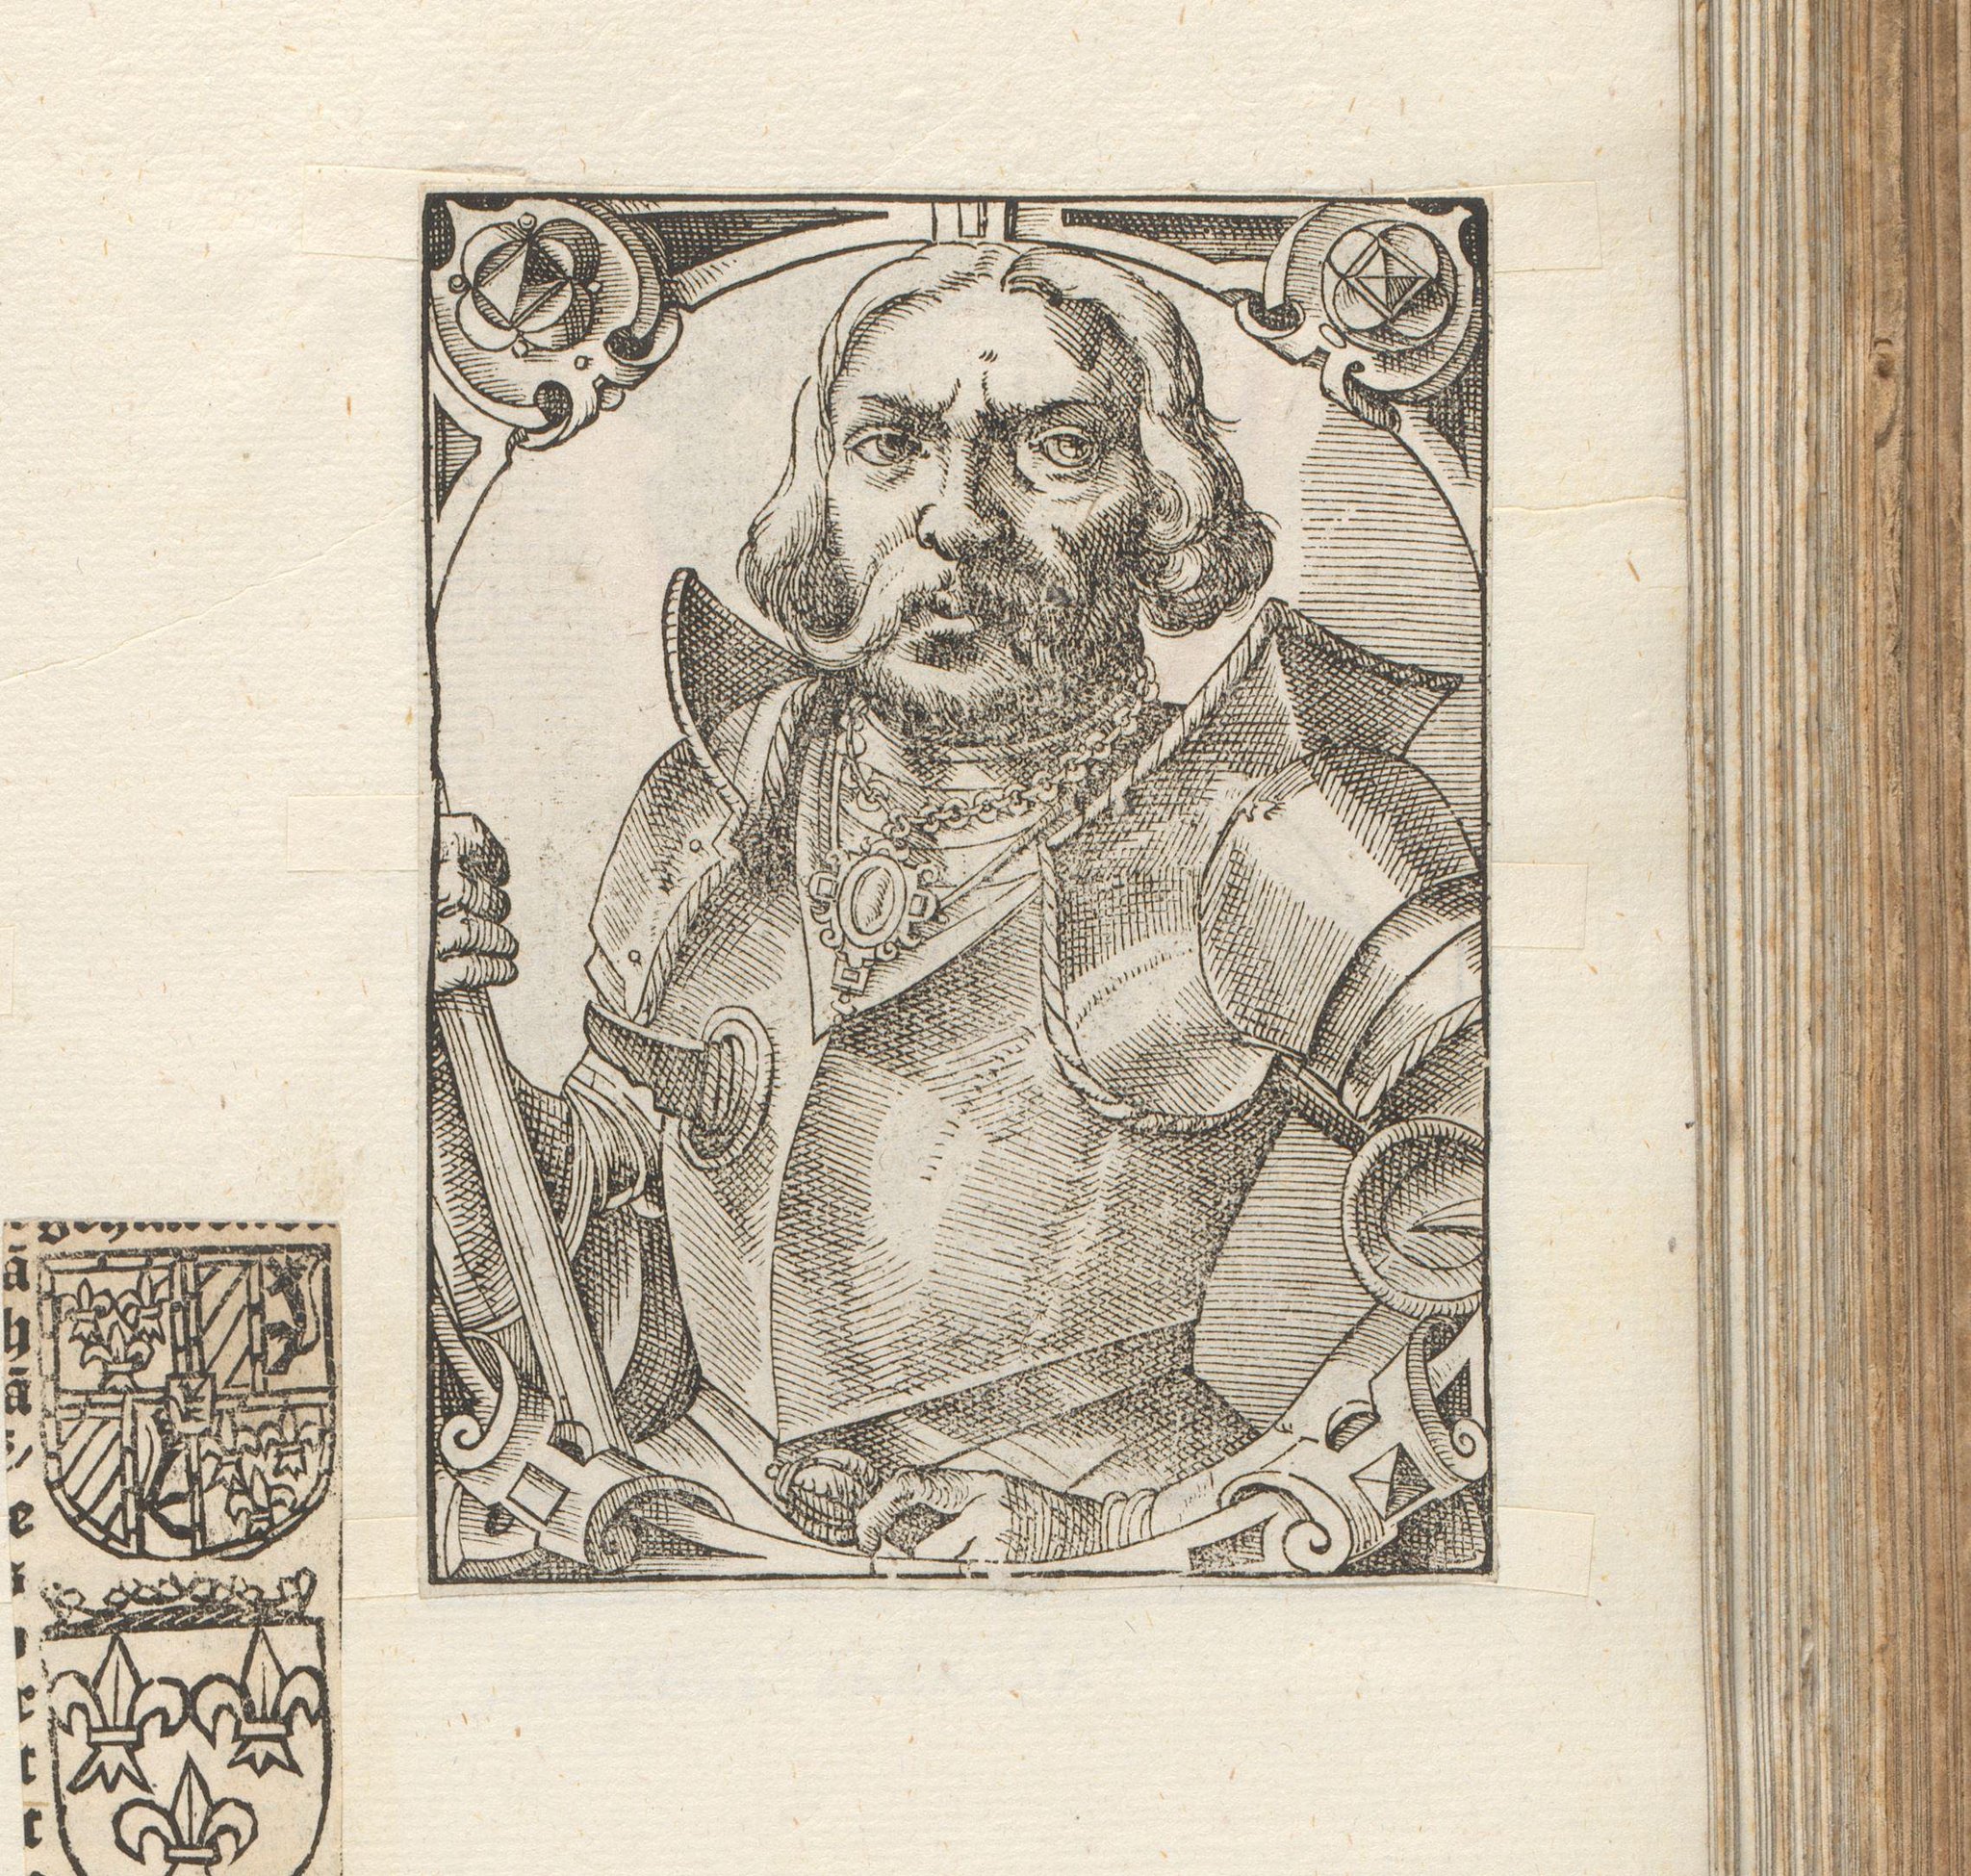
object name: album leaf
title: Portret van Francesco Gonzaga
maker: Anonymous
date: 1549-1577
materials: paper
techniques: woodcut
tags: commander-in-chief, general, marshal, historical persons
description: Prent gebruikt in: Giovio, Paolo. Musaei Ioviani Imagines (...). Bazel: Peter Perna, 1577.